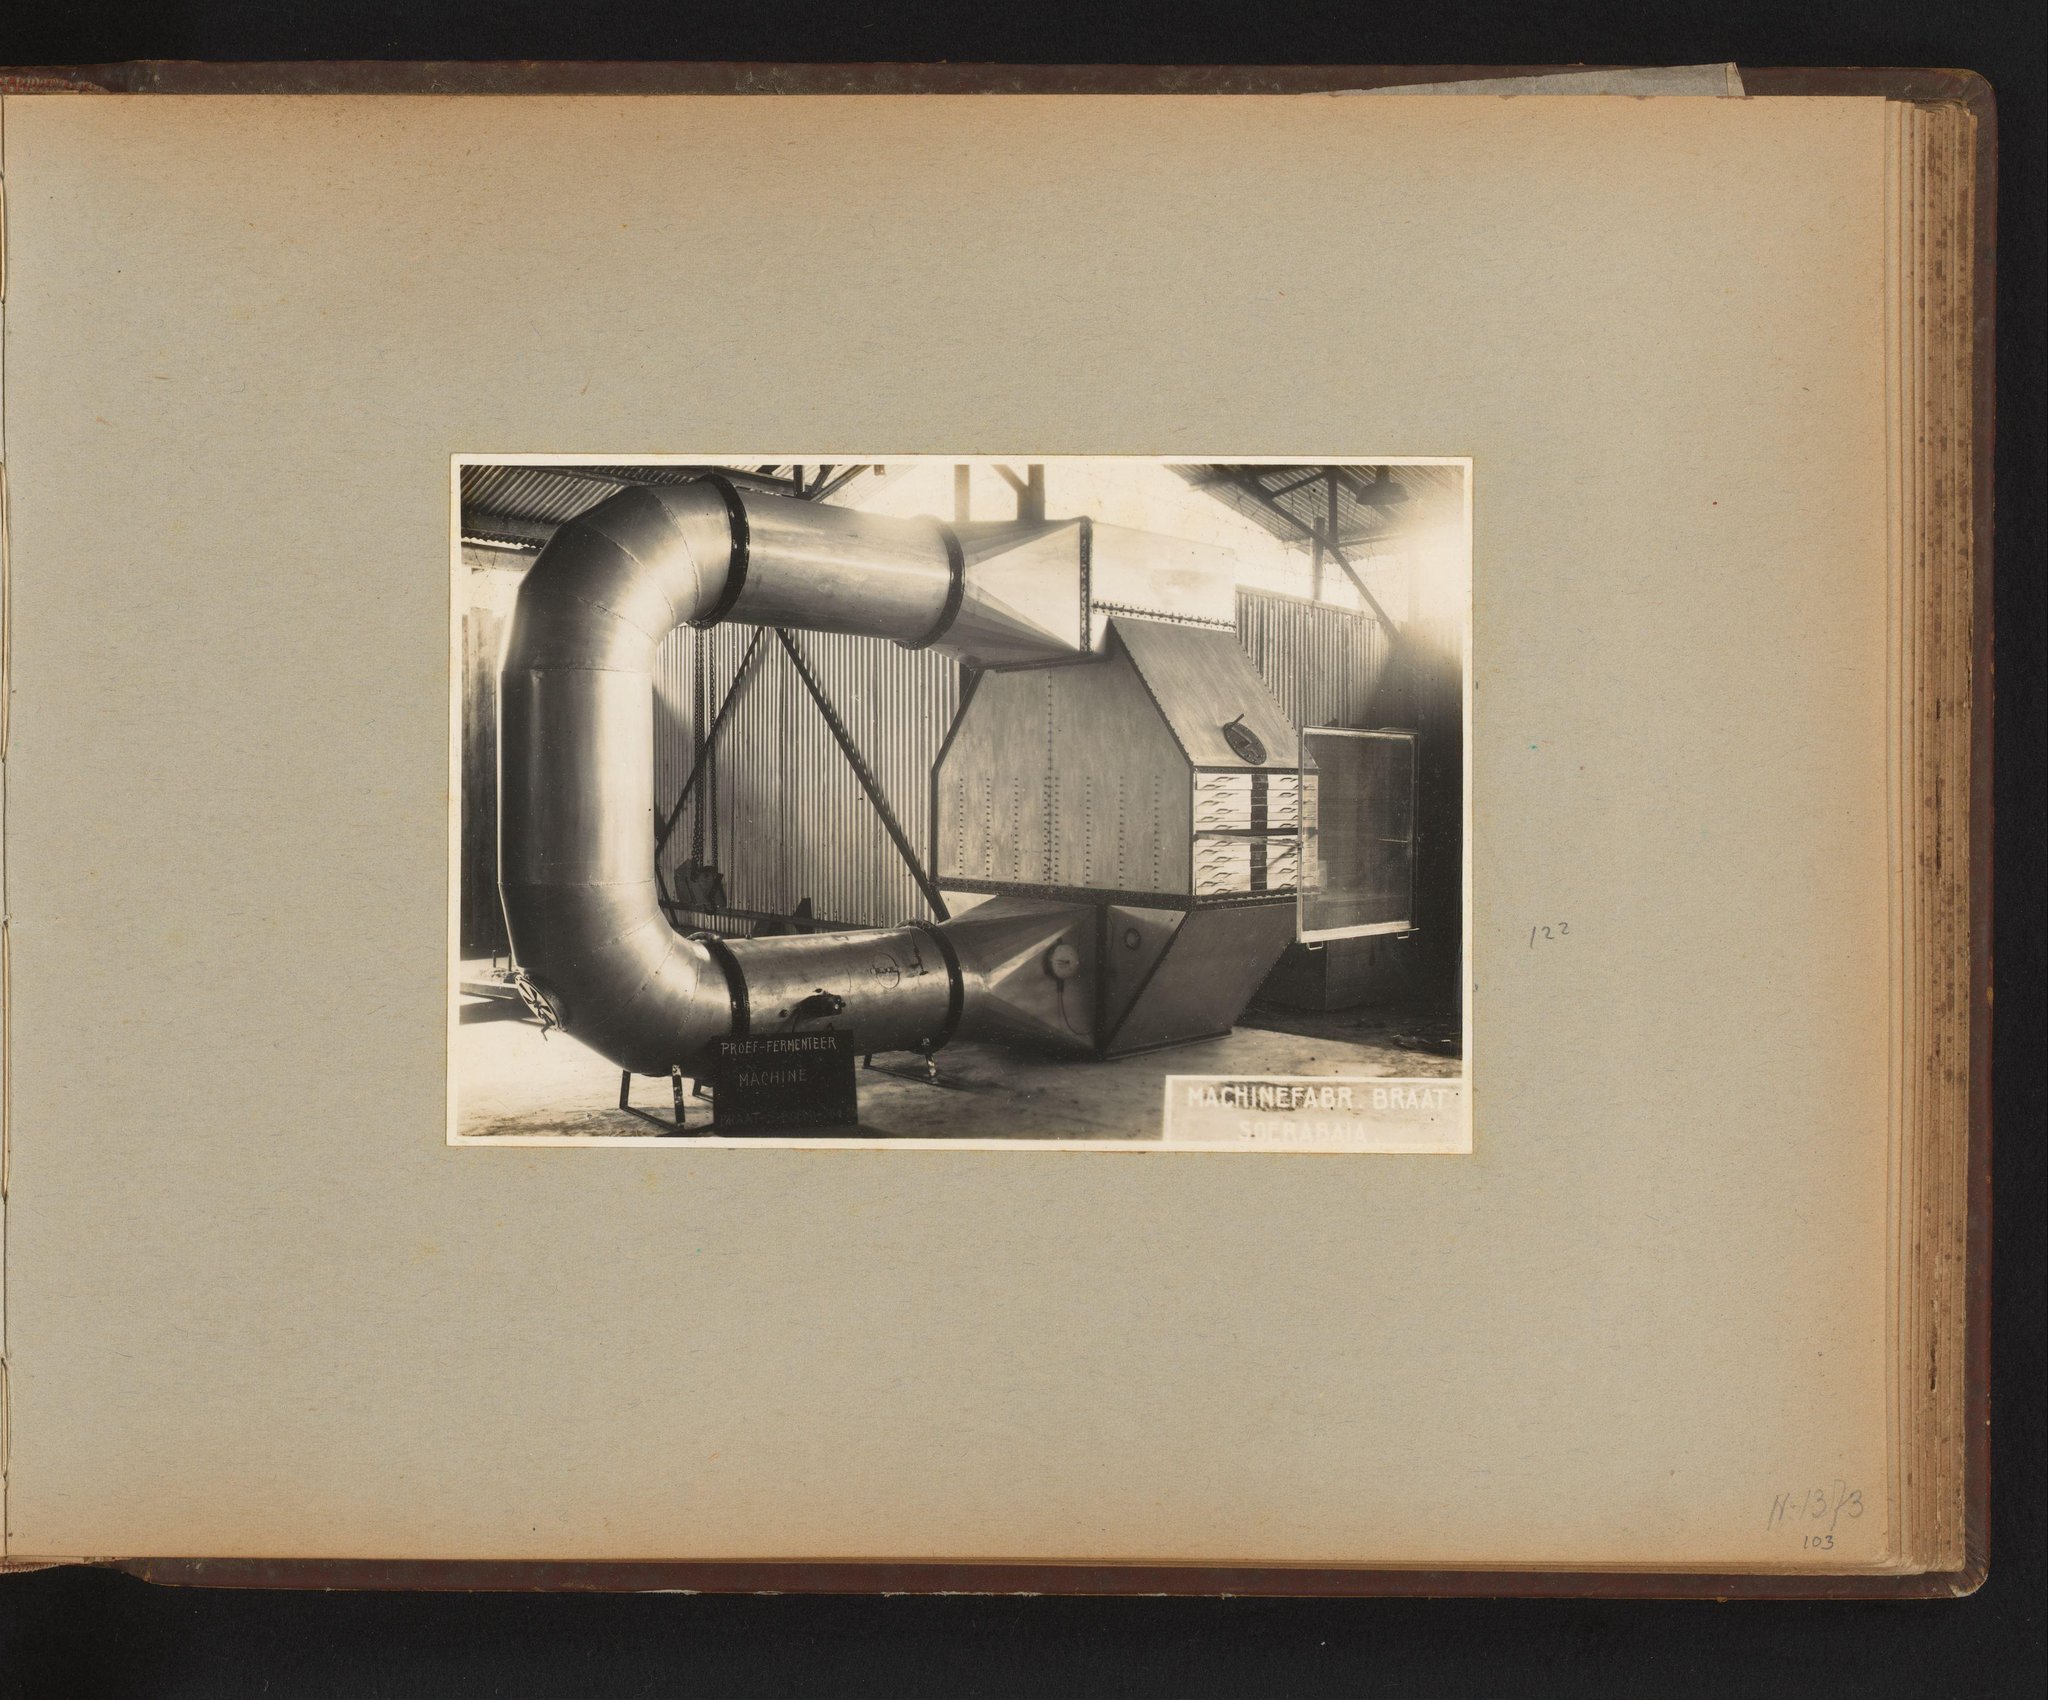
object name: album leaf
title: Proef-fermenteermachine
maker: Anonymous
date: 1936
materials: cardboard, photographic support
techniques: gelatin silver print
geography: soekaboemi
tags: factory-interior, machine shop, machines; parts of machines; tools and appliances, java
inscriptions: date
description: Albumblad met een foto van een proef-fermenteermachine, 30 januari 1936. Onderdeel van een fotoalbum met foto's van machines en constructies van de N.V. Machinefabriek Braat te Soerabaja, Soekaboemi en Tegal uit de periode 1931-1937.